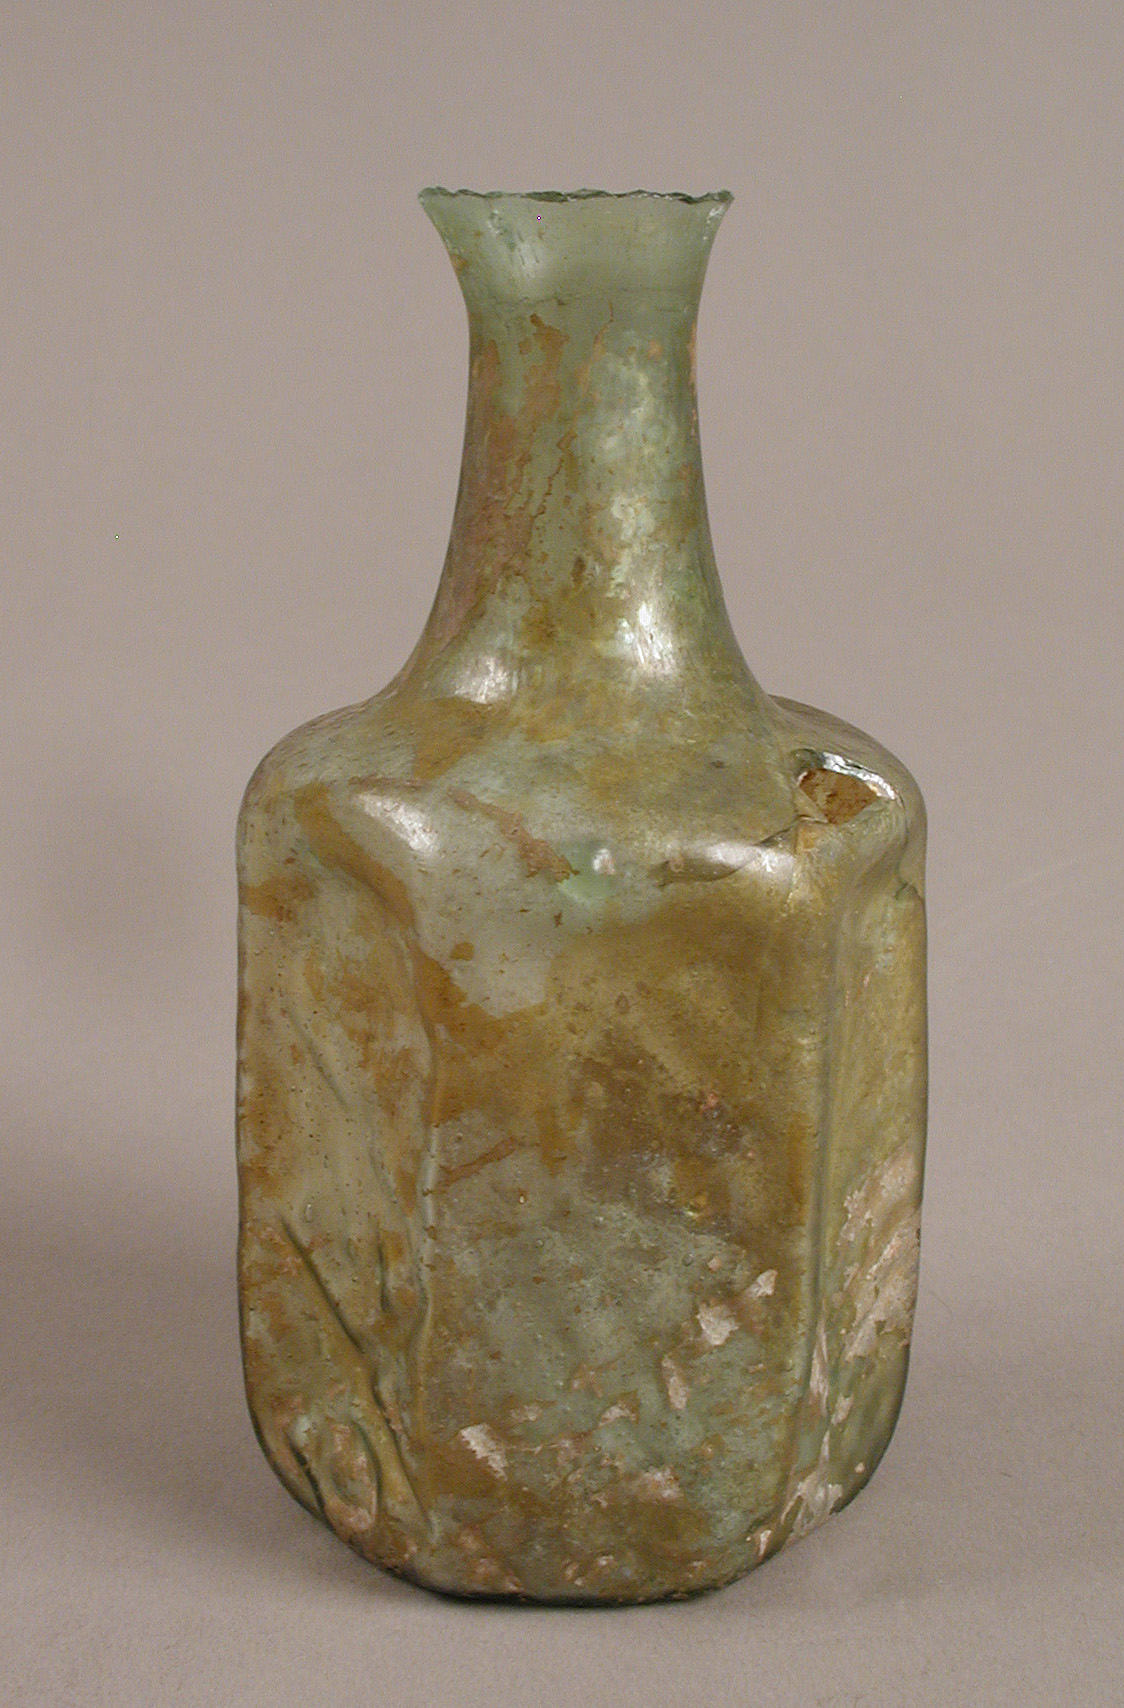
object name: flask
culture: byzantine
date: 301-500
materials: glass